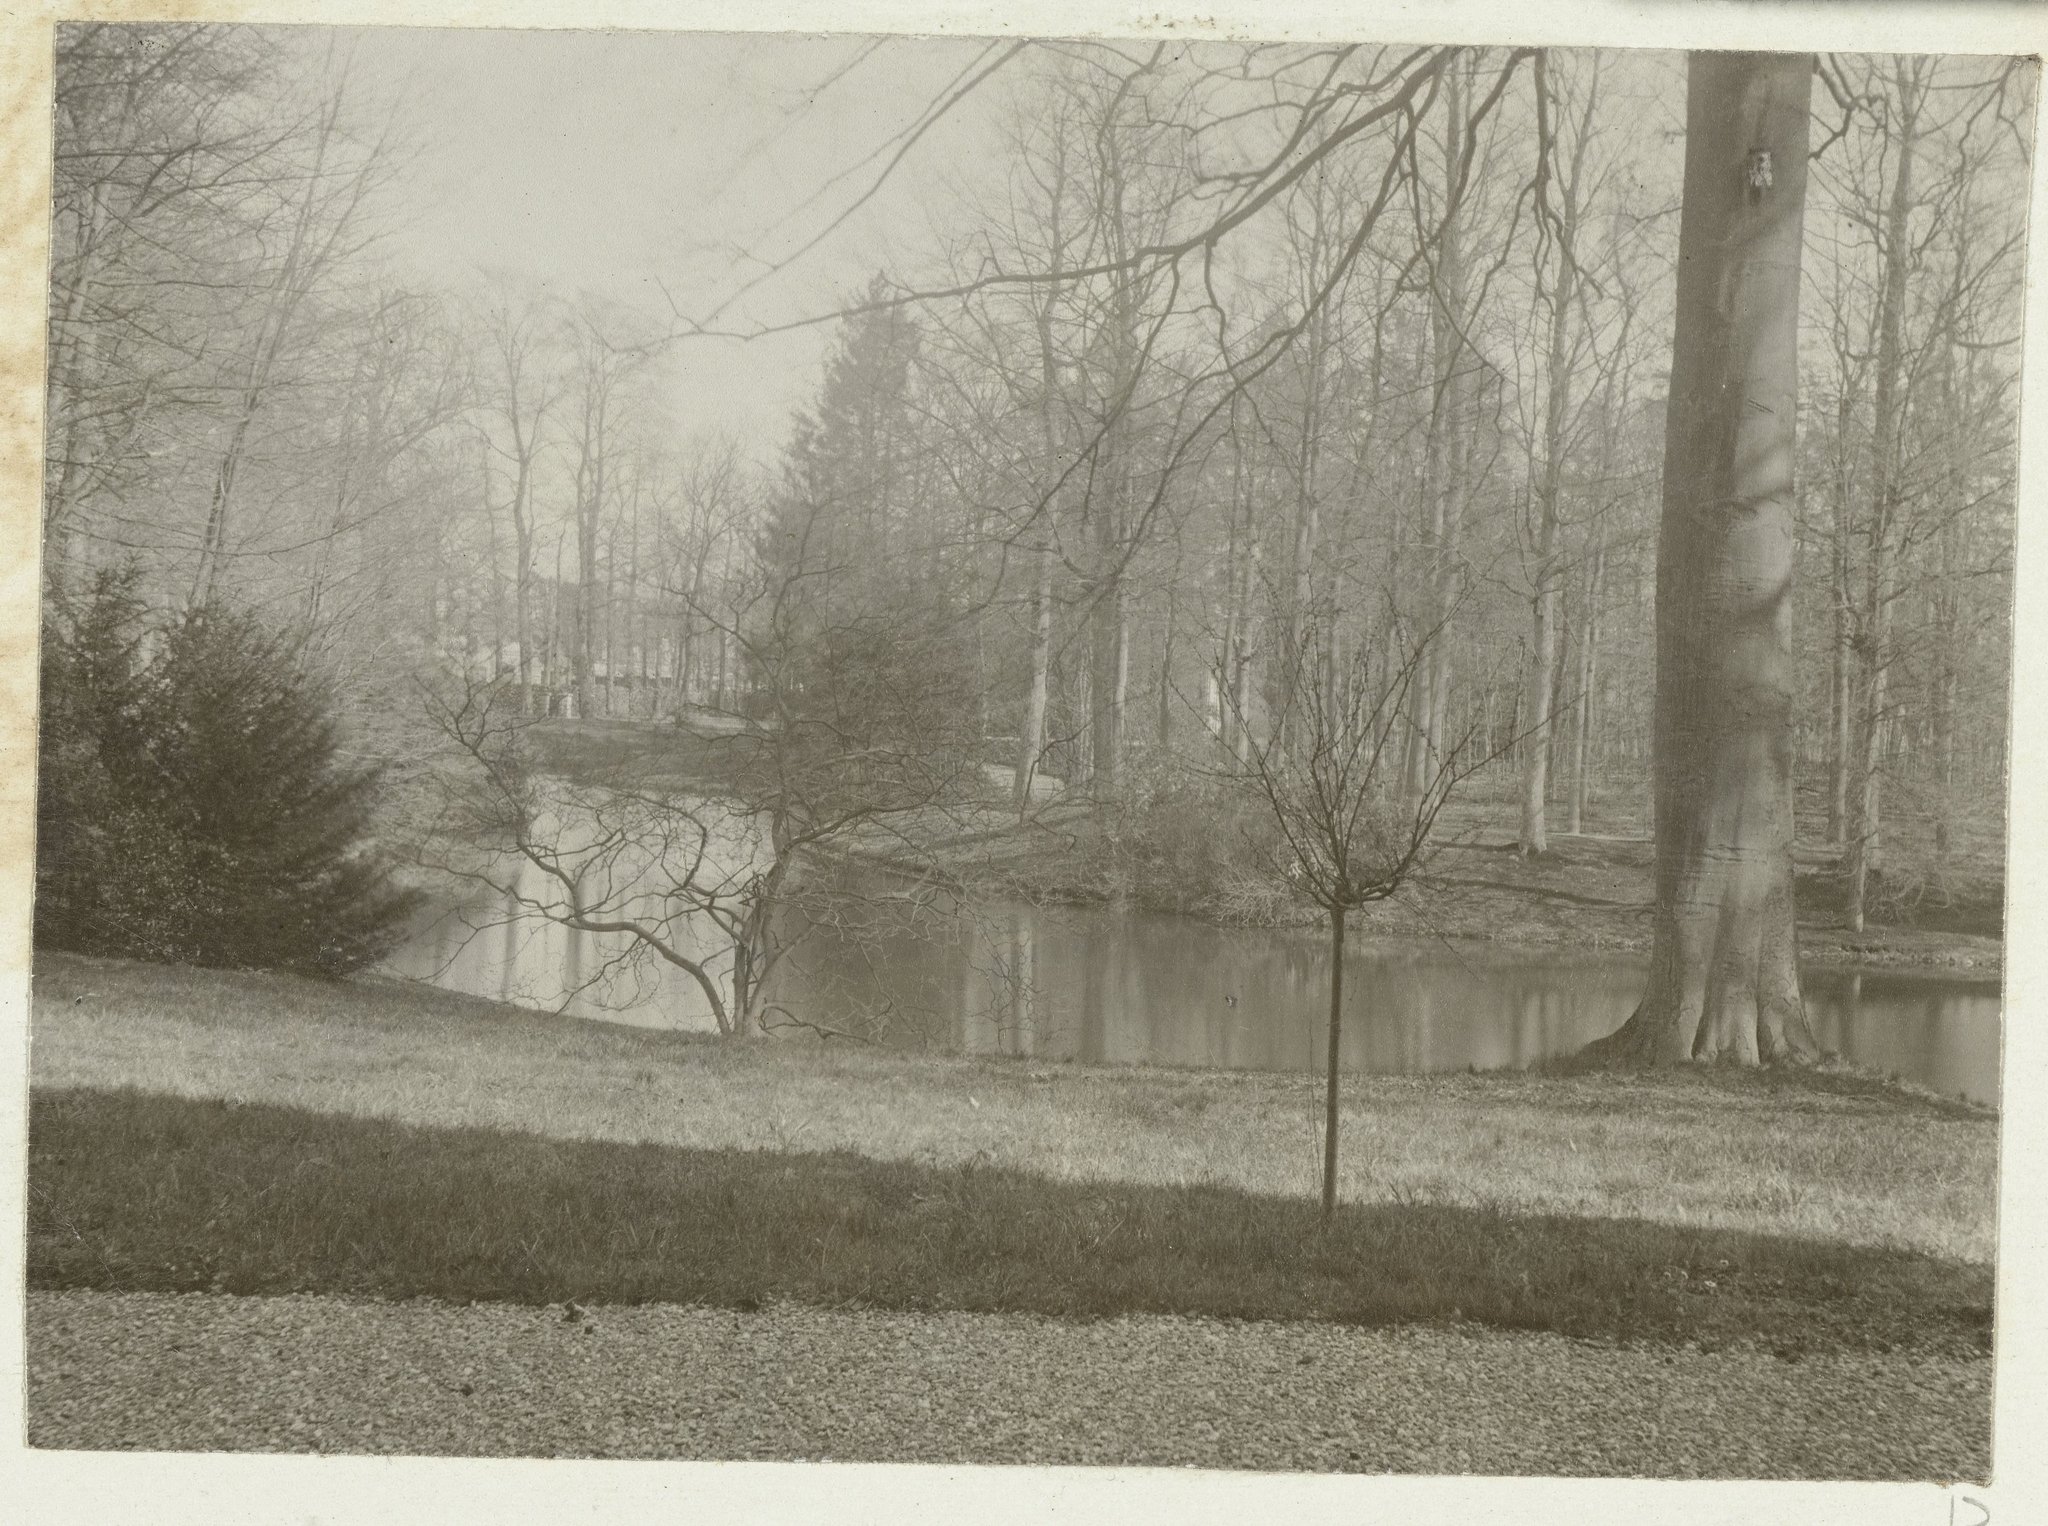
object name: photograph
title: Gezicht in het park van landhuis De Wildbaan, Driebergen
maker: henry pauw van wieldrecht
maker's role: fotograaf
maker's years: 1863-1912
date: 1903-1907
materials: paper, photographic support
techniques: gelatin silver print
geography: netherlands